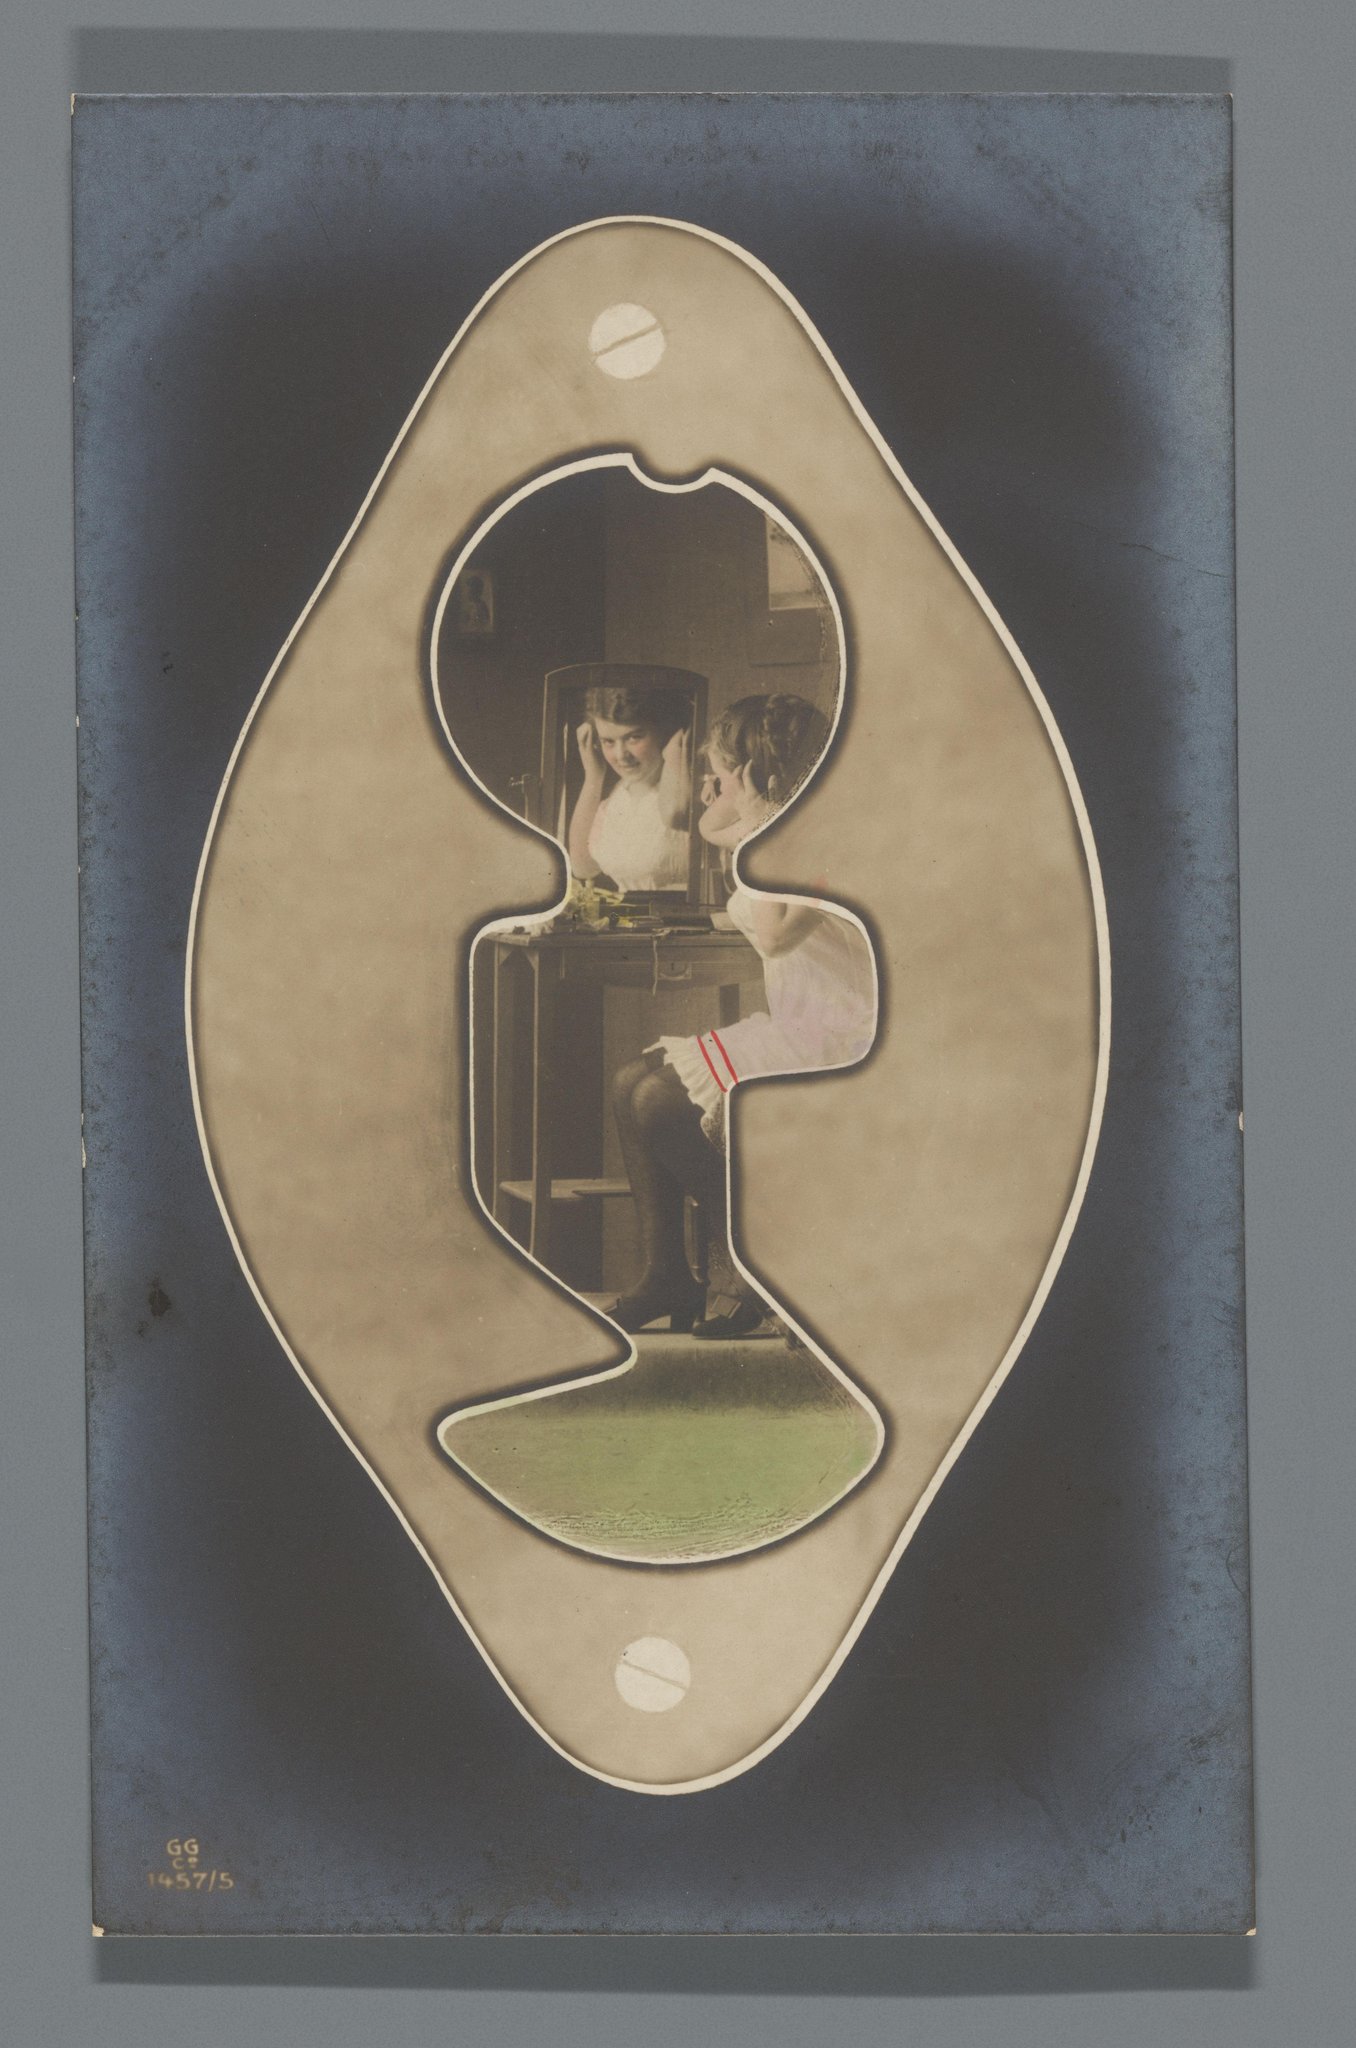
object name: ansichtkaart, prentbriefkaart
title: Vrouw die zich ontkleedt en opmaakt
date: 1920-1930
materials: paper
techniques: gelatin silver print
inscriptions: inscription: ‘GG / Co / 1457/5’, inscription: ‘P.R.A.’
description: Een van zes postkaarten/prentbriefkaarten met een voorstelling van een vrouw die zich ontkleedt en opmaakt, gezien door een sleutelgat.